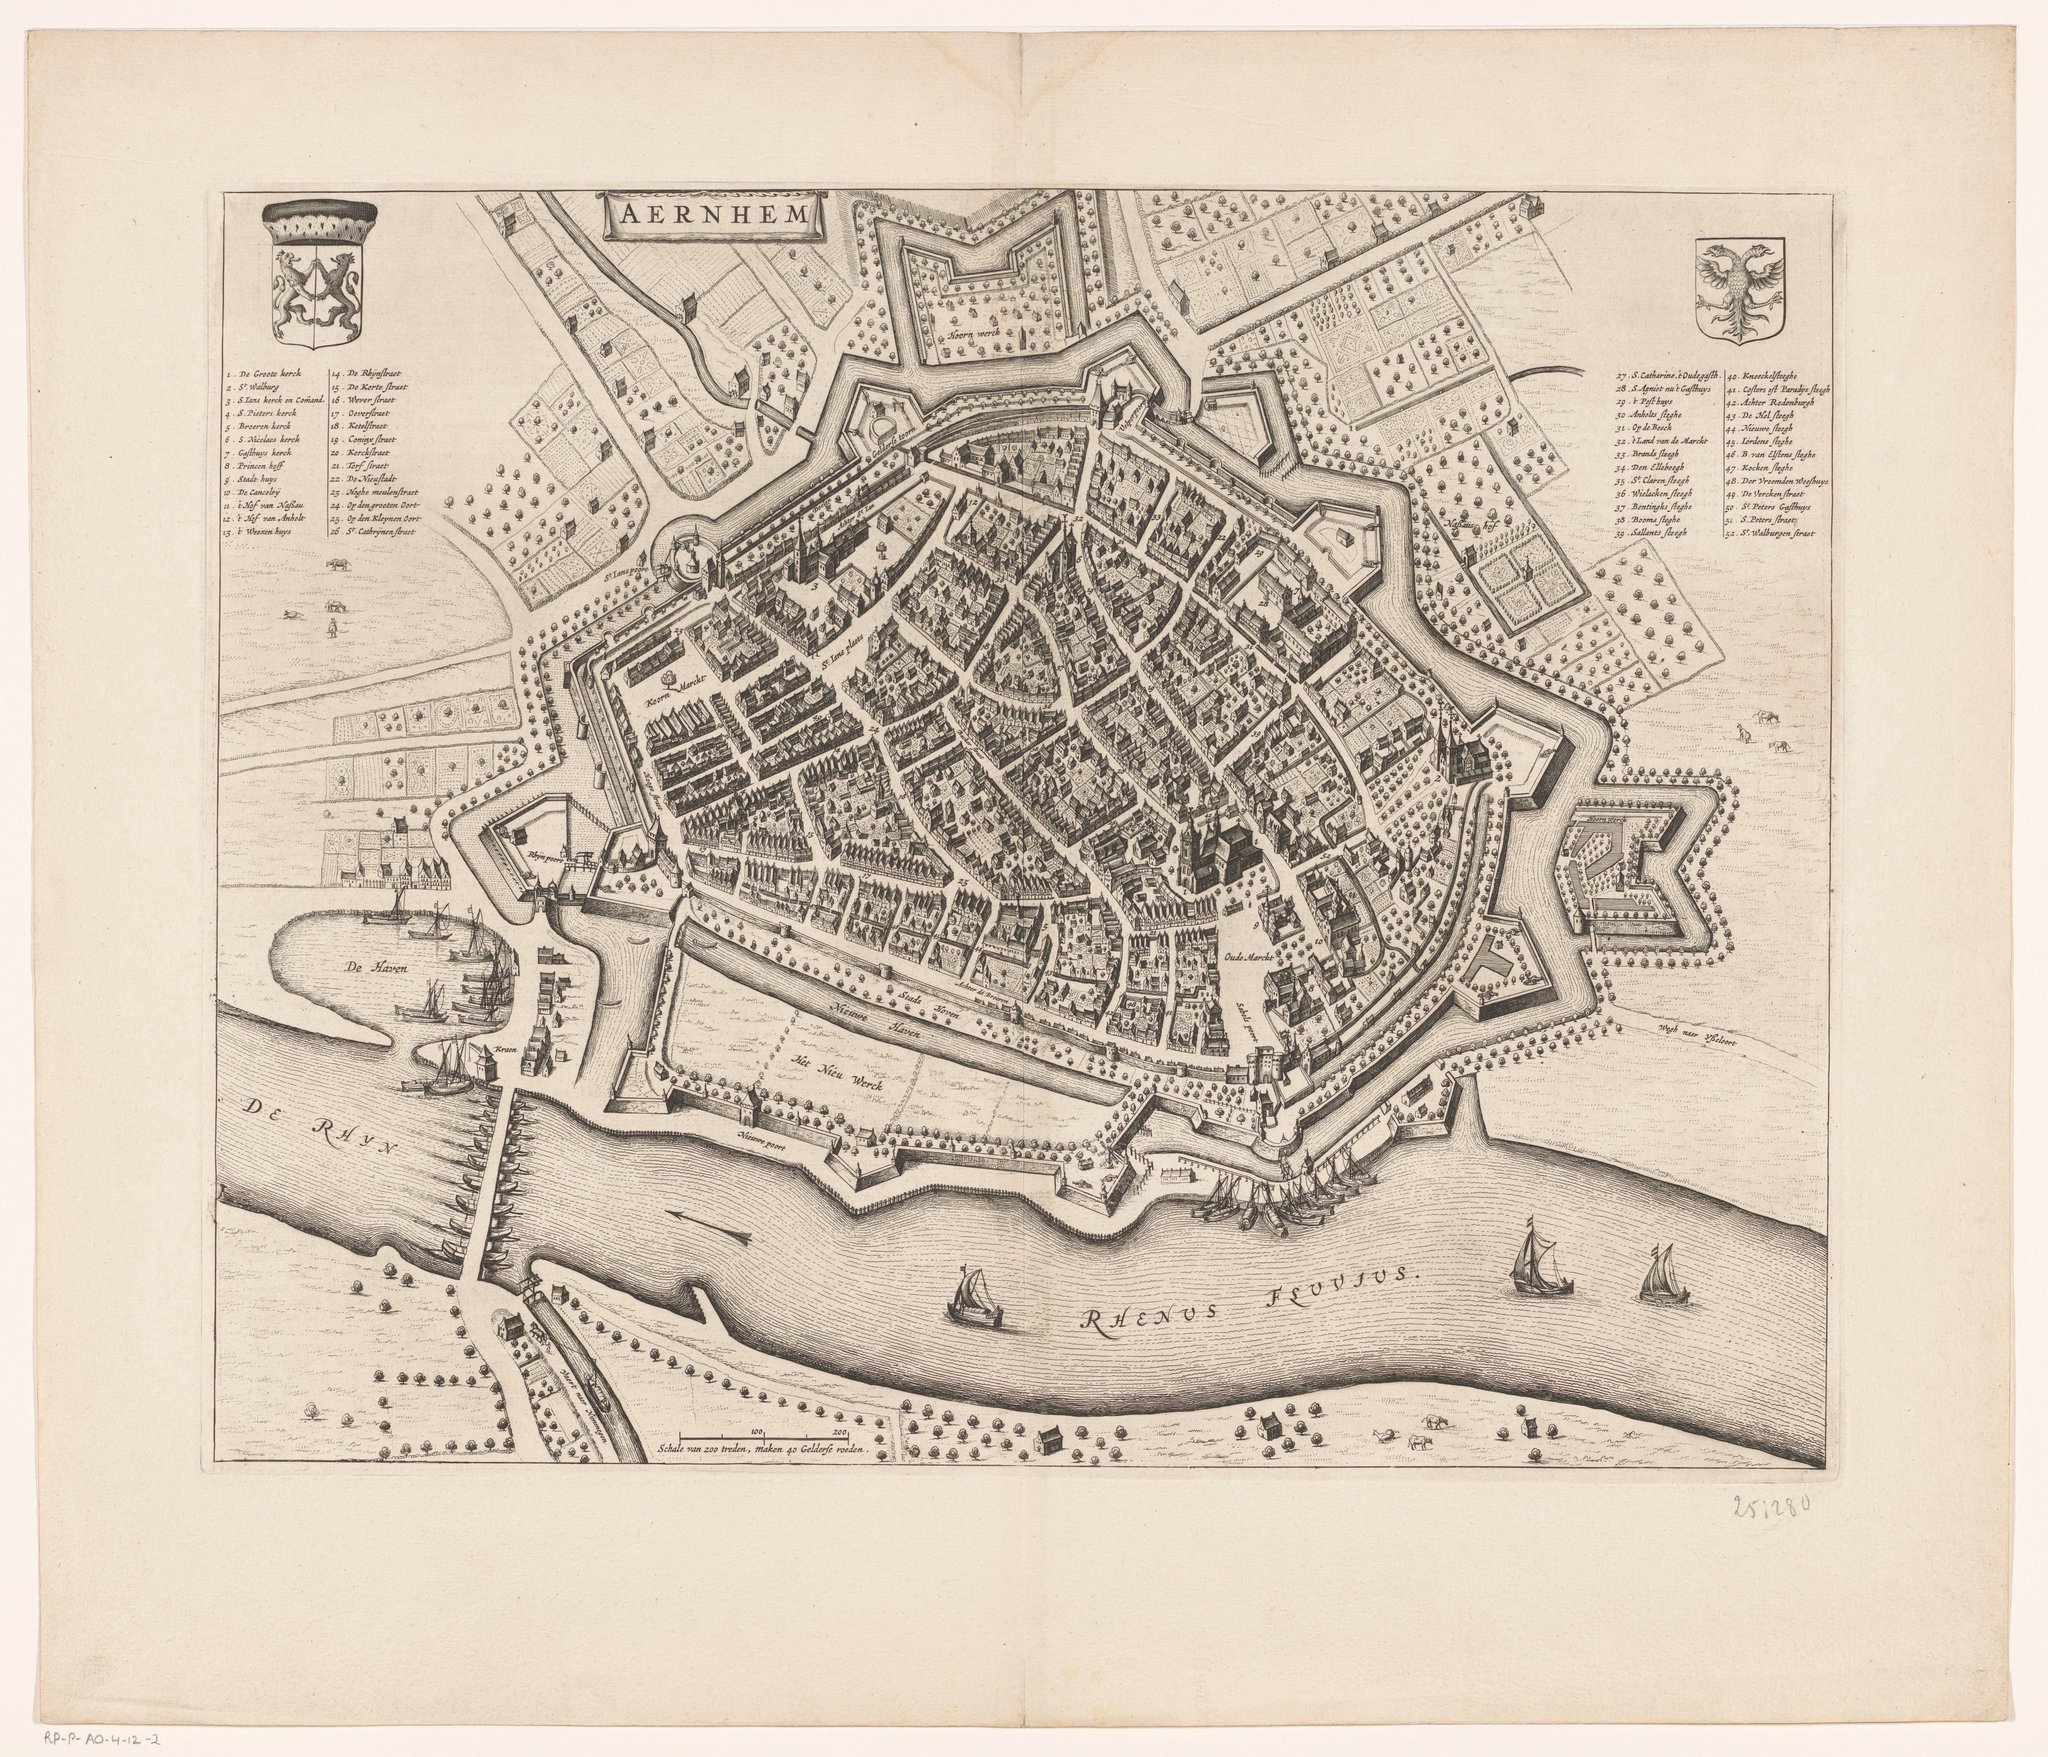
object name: area plan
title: Plattegrond van Arnhem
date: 1652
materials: paper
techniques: engraving, etching, letterpress printing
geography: amsterdam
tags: coat of arms (as symbol of the state, etc.), maps of cities, gelderland, arnhem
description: Plattegrond in vogelvluchtperspectief. Linksboven het wapen van Gelderland, daaronder een legenda. Onderaan een schaalstok: Schale van 200 treden, maken 40 Gelderse roeden. Rechtsboven het wapen van Arnhem, daaronder een legenda. Op verso Latijnse tekst.